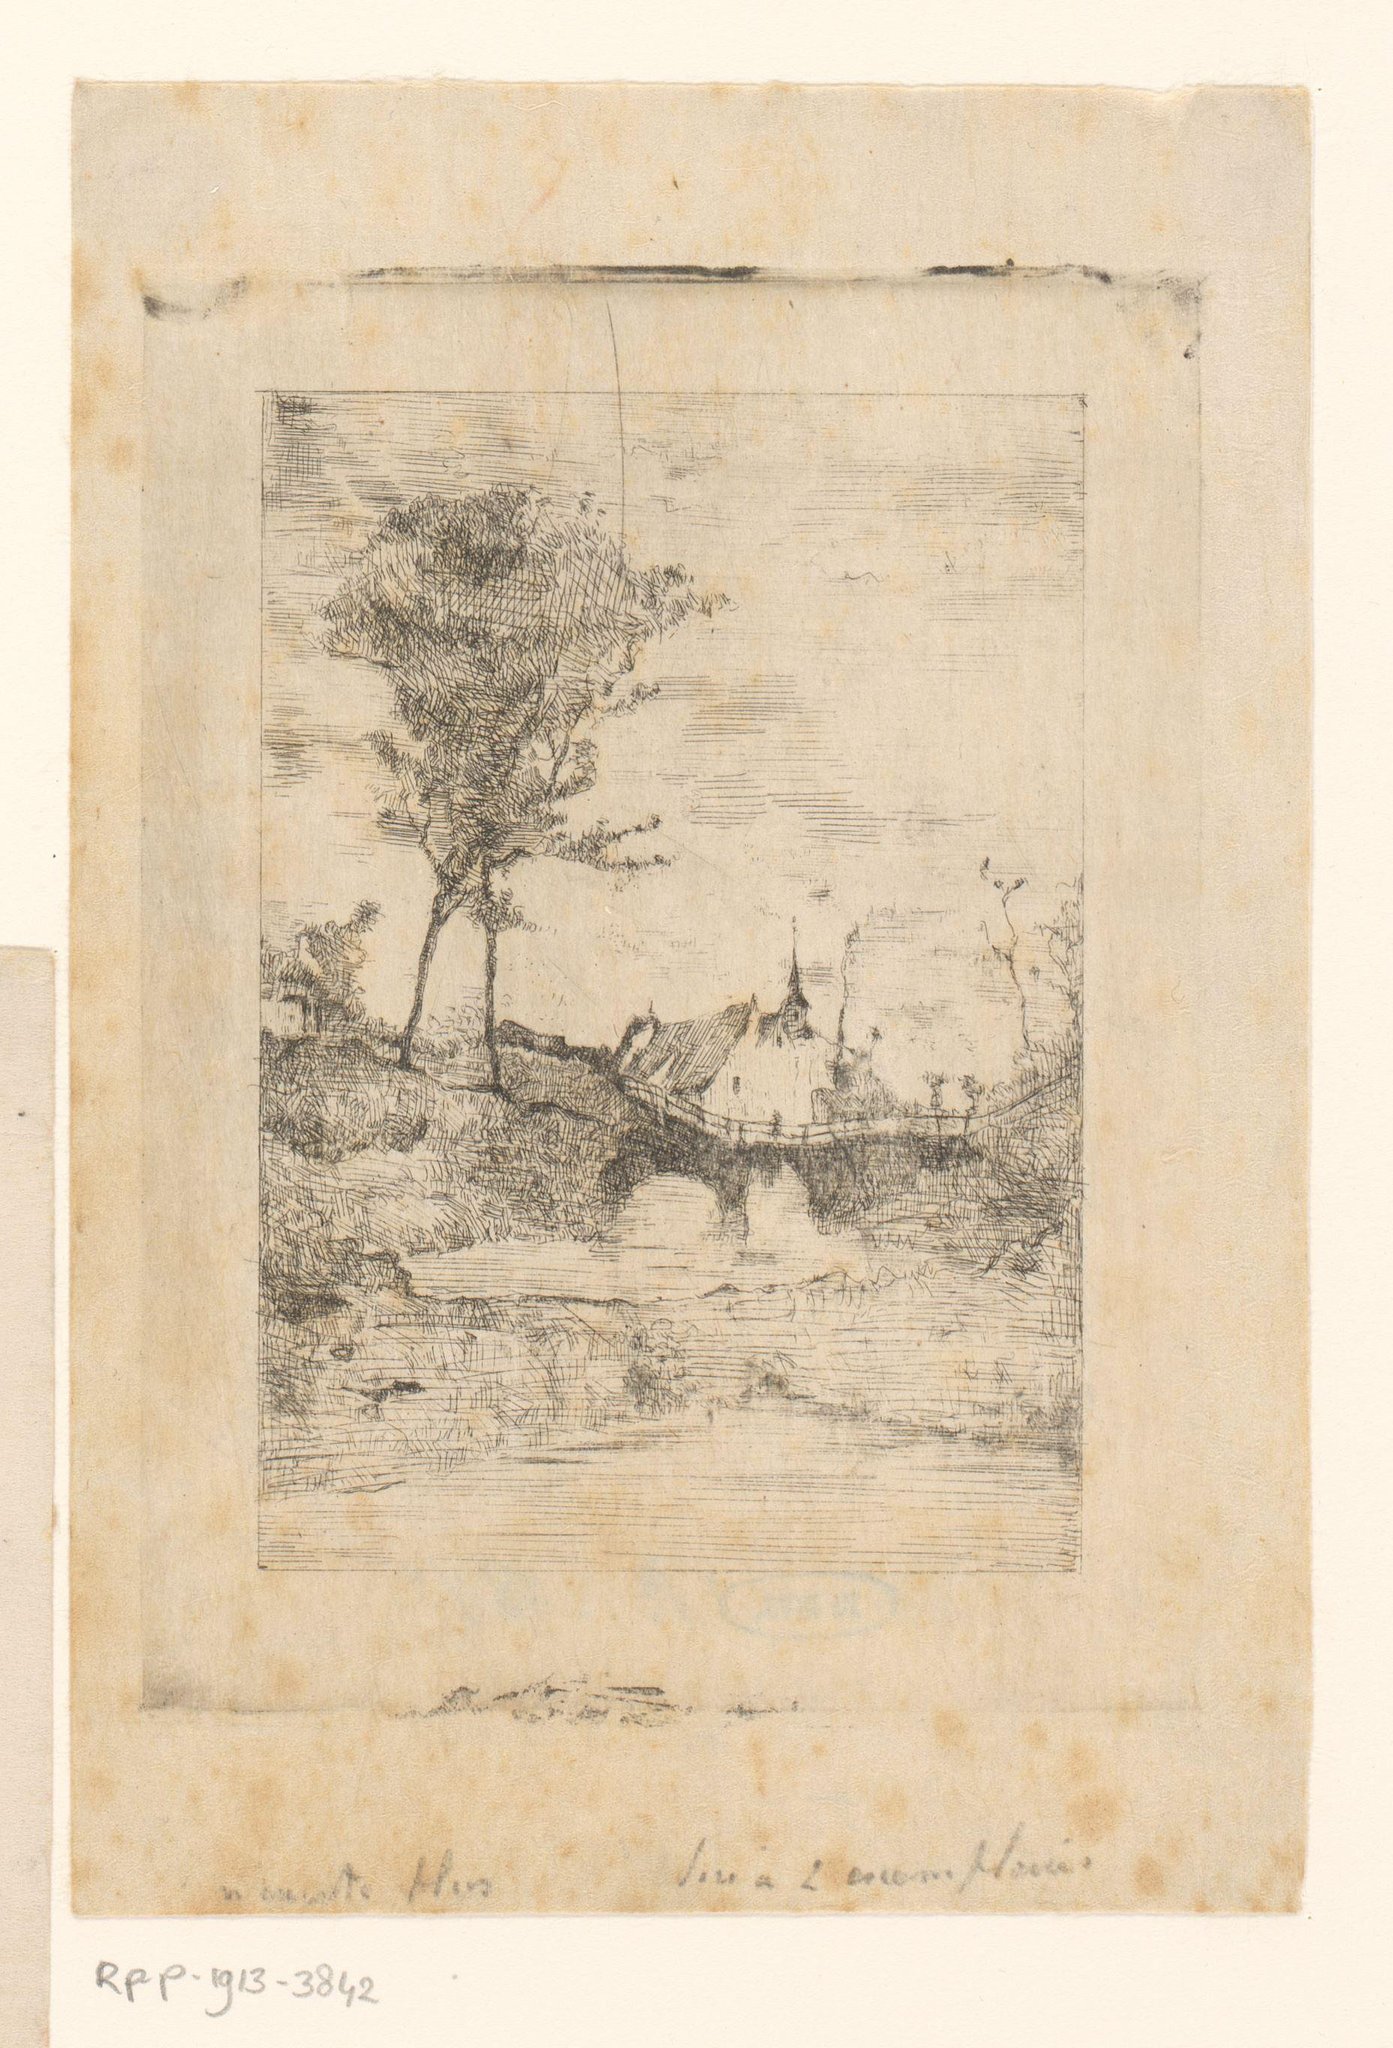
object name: print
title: Landschap met brug en enkele gebouwen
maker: piet verhaert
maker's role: print maker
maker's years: 1852-1908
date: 1862-1908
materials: paper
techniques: etching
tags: landscape with bridge, viaduct or aqueduct, bridge in village across river, canal, etc.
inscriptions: inscription: ‘[...] Tire a 2 examplaire’, collector's mark: Lugt 2228